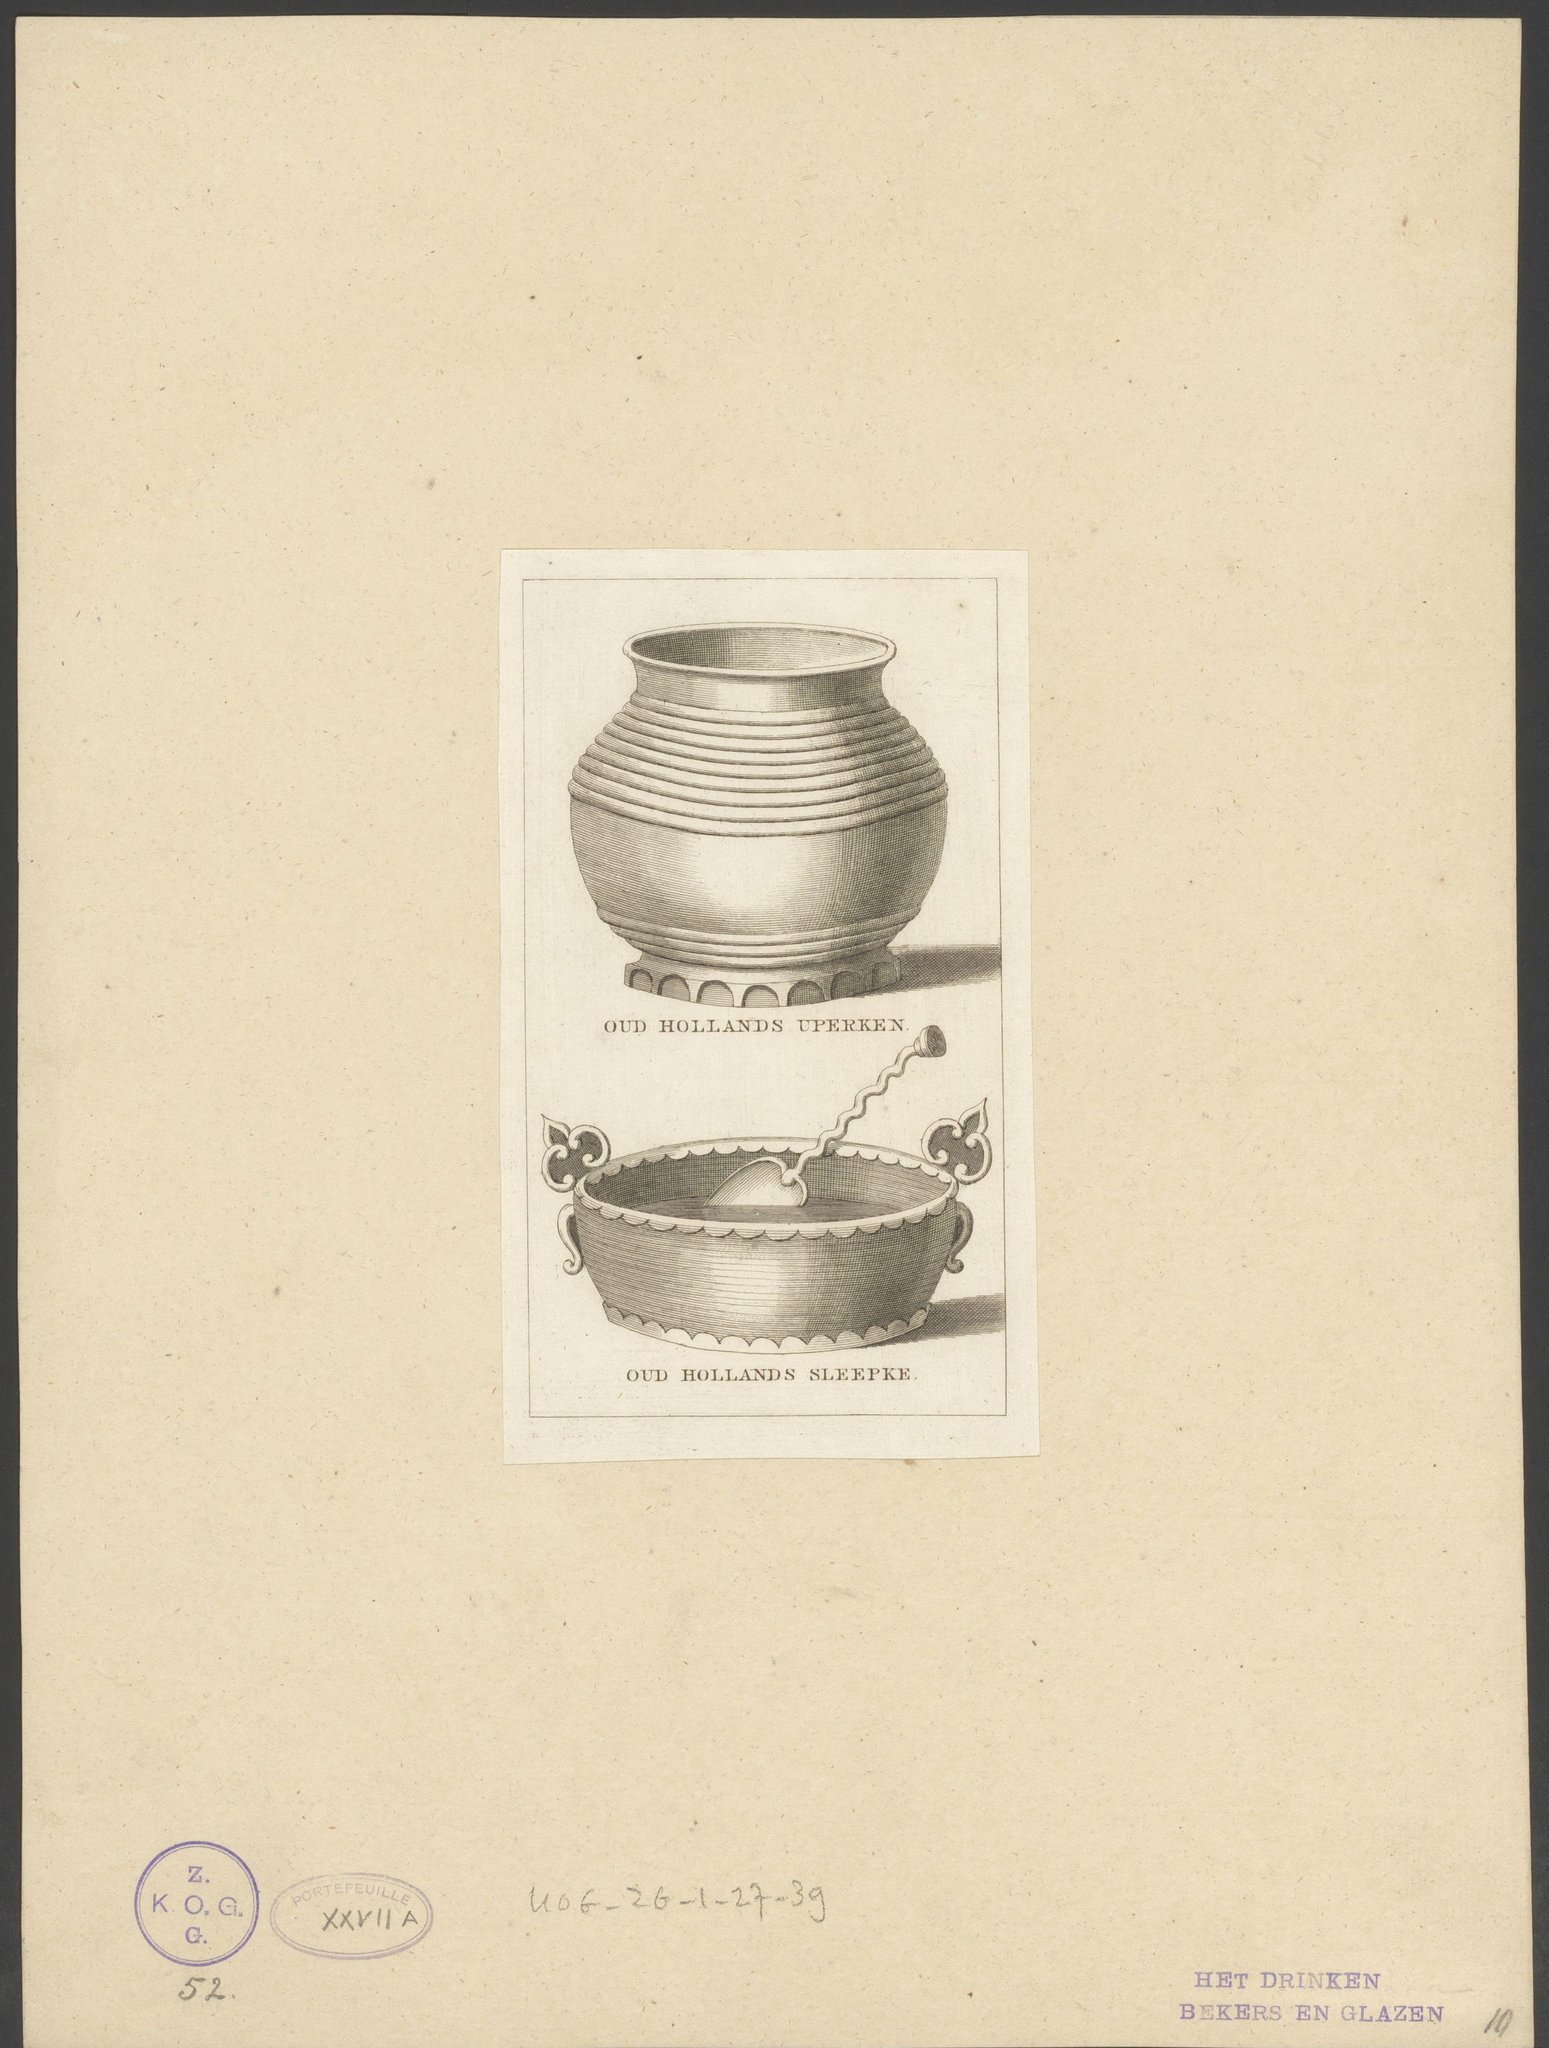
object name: print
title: Oud Hollands uperken / Oud Hollands sleepke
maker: Anonymous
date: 1808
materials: paper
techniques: etching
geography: netherlands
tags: mug, beaker, goblet, alcoholic drinks, dish, plate, saucer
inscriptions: collector's mark, collector's mark: Lugt 1641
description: Gebruikt als illustratie in: J. Le Francq van Berkhey, Oud Hollands Vriendschap, tot Leydens Troost bij haren Ramp in den Jare 1807, Leiden: J. van Thoir, 1808, p. 98/99.